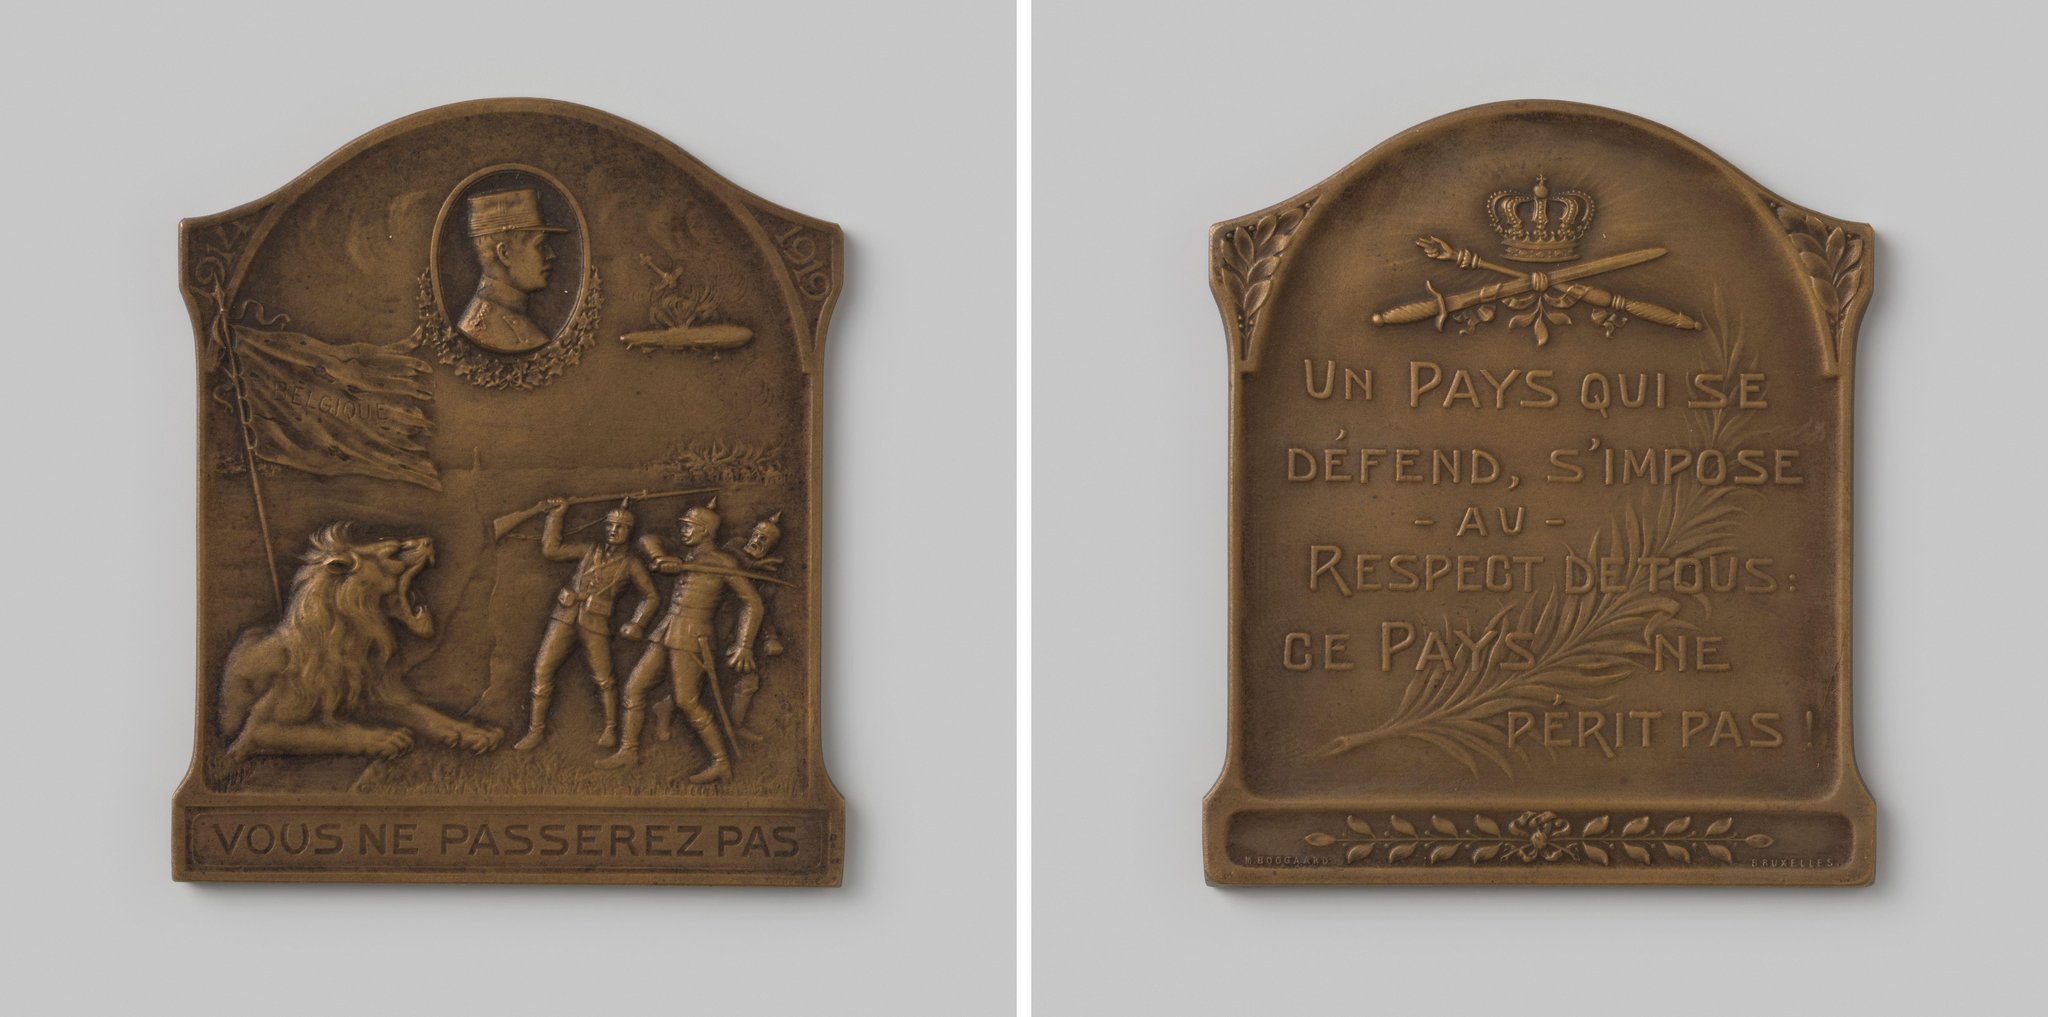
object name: history medal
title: België in oorlog 1914-1919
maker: m. boogaard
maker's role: die cutter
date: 1919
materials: bronze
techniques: striking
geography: brussels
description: Bronzen plaquete met gewelfde bovenkant, op de voorzijde een landschap met de rivier de IJzer waar een brullende leeuw met vlag drie soldaten met pickelhauben onder een zeppelin verschrikt, bovenaan een ovaal portretmedaillon van Koning Albert en onderaan een tekstband, op de keerzijde zes regels tekst rond een palmtak onder een kroon, zwaard en scepter, met bloemversieringen.